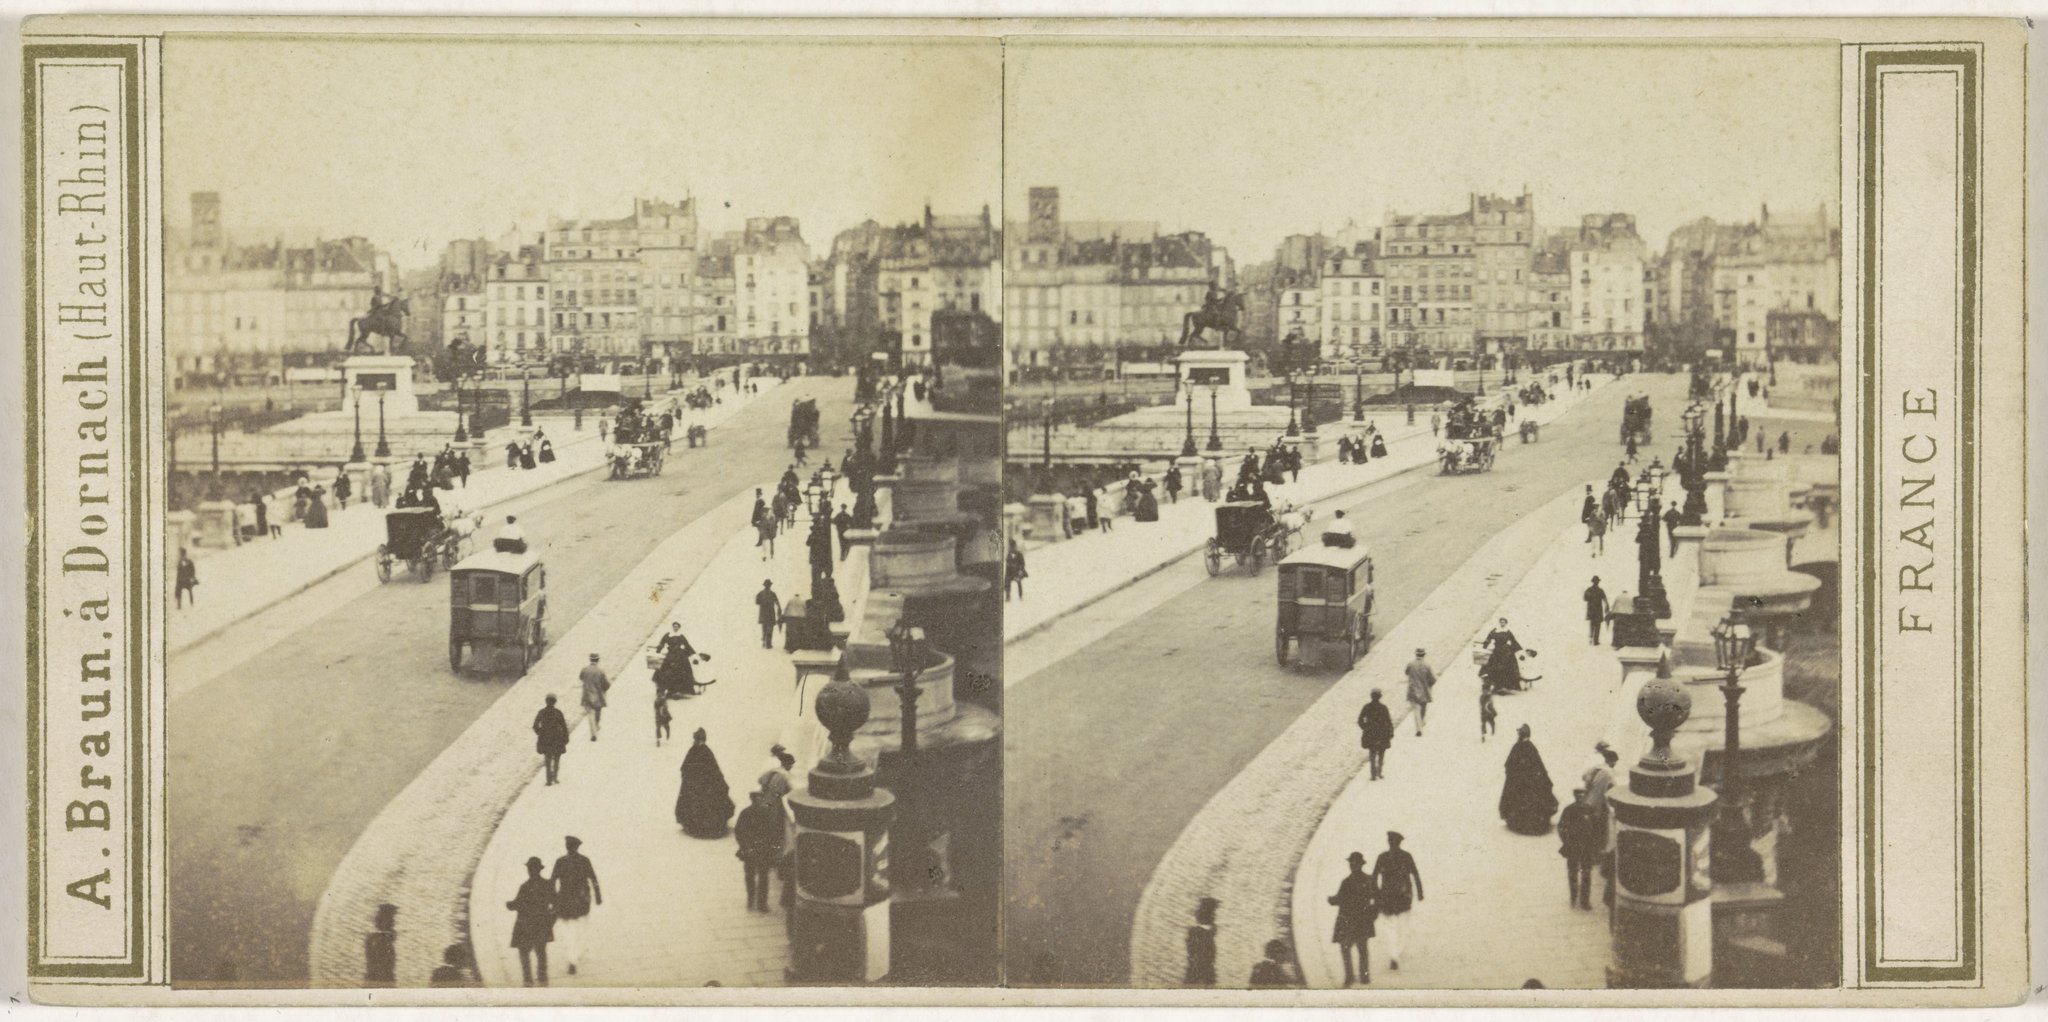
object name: stereograph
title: Gezicht op de Pont Neuf, Parijs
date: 1860-1870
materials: cardboard, paper, photographic support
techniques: albumen print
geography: france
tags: pont neuf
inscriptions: label: ‘N° 1720. / Paris. Pont-Neuf. Vue instantanée.’, inscription: ‘€650 / 250,’